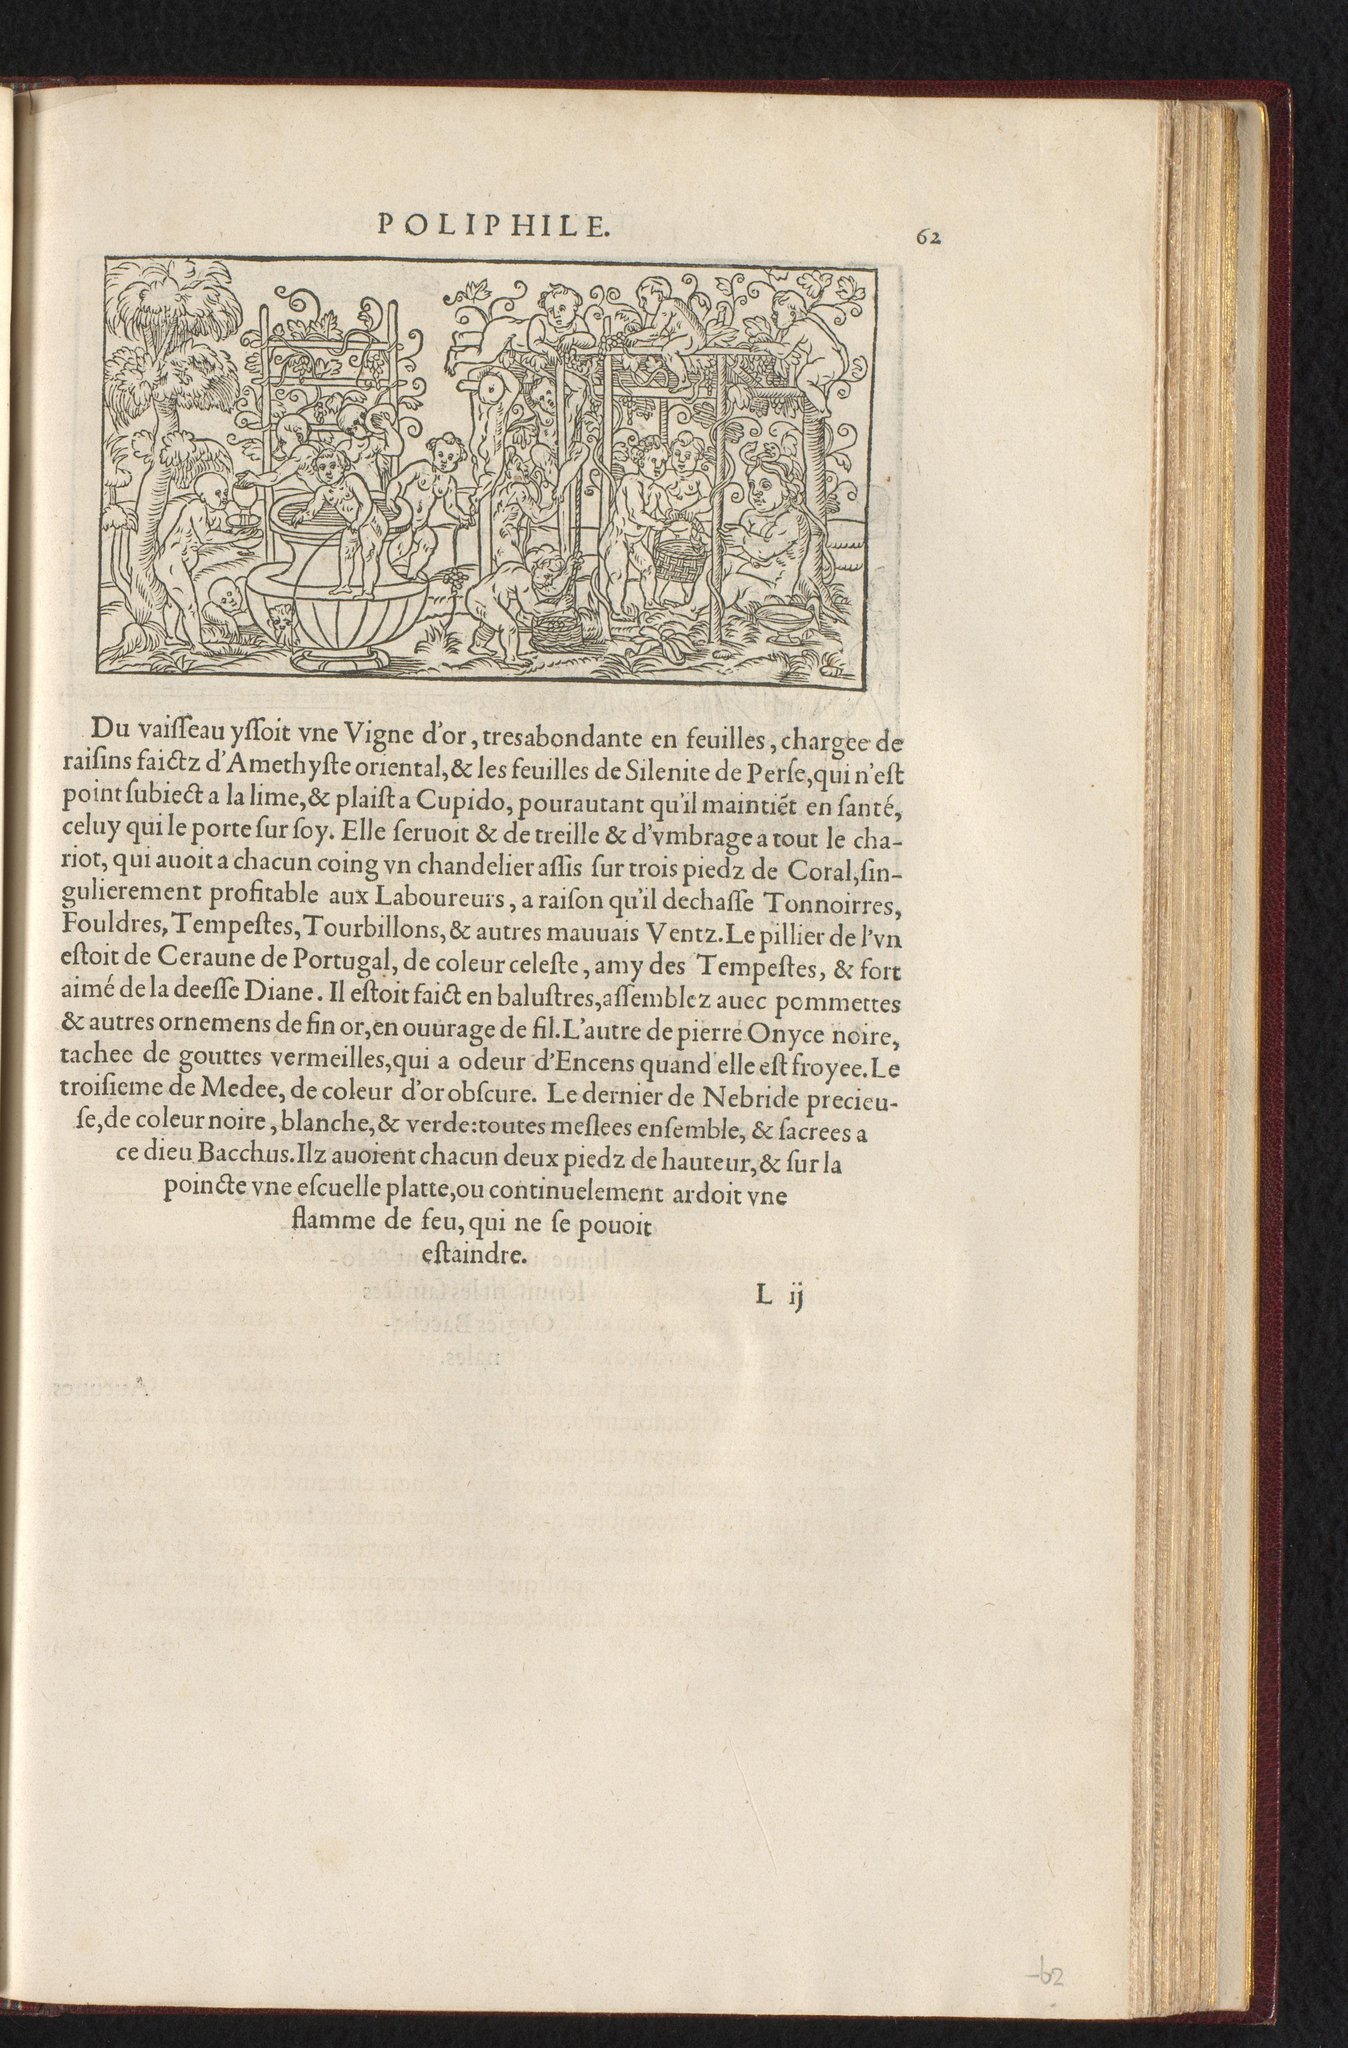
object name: book illustration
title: Groep putti rond wijnranken en een vat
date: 1546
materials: paper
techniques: letterpress printing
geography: paris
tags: vine, (scenes from) specific works of literature: colonna, hypnerotomachia poliphili, cupids: 'amores', 'amoretti', 'putti'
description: Prent uit: Colonna, Francesco. Hypnerotomachie ou discours du songe de Poliphile, deduisant comme amour le combat a l'occasion de Polia. Parijs: Jacques Kerver, 1546, recto fol. 62.